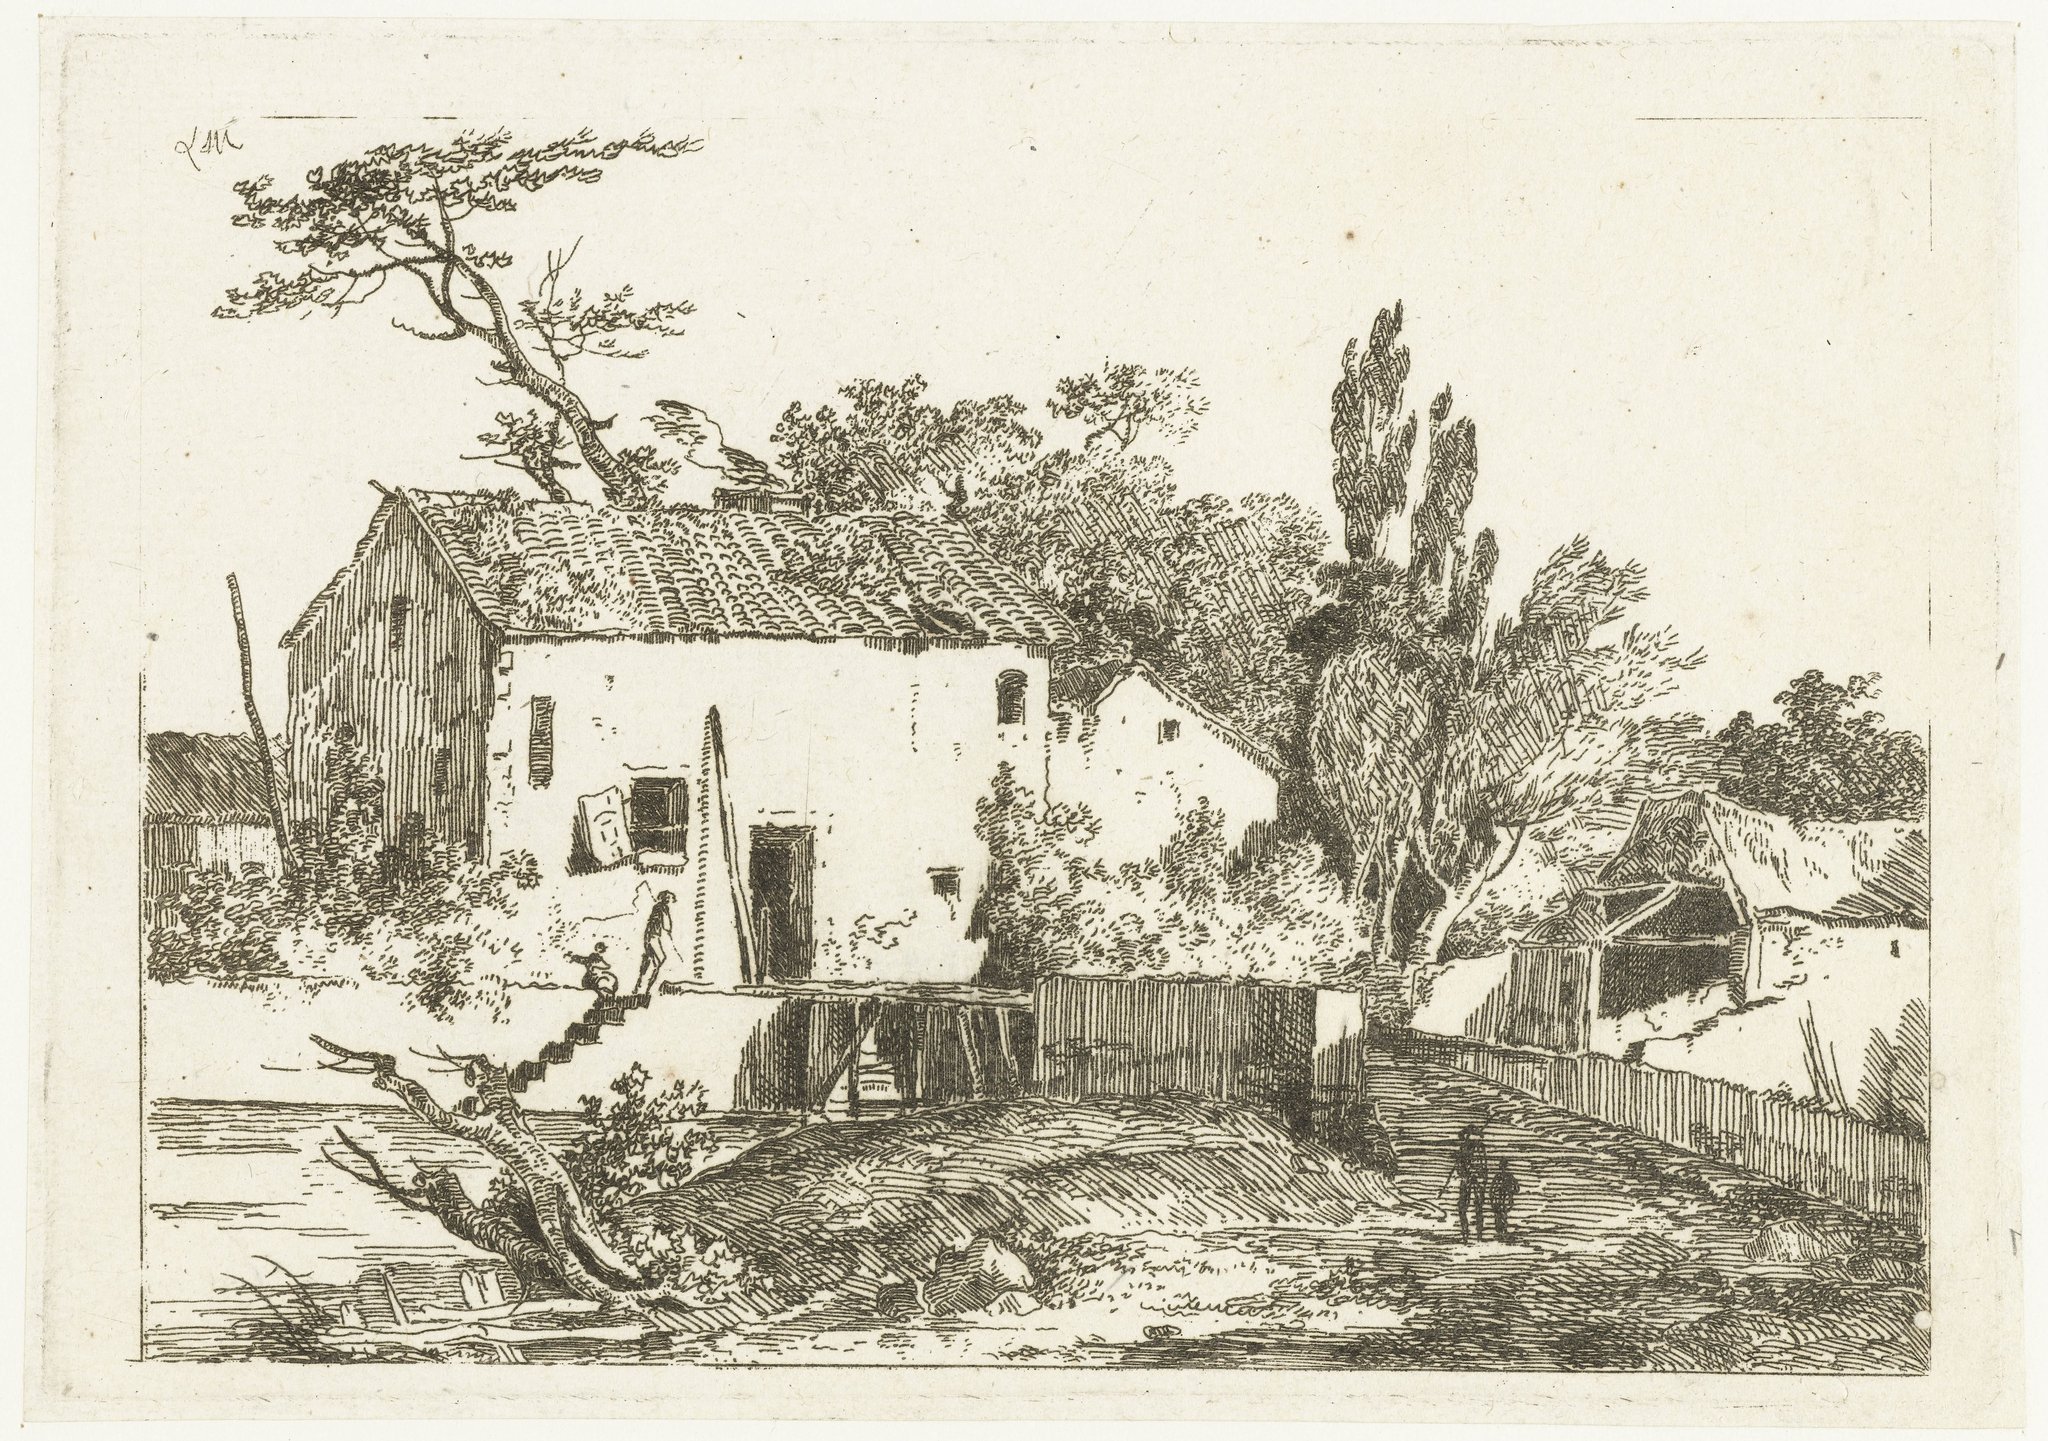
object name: print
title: Landweg naar een huis aan het water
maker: louis gabriel moreau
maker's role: draughtsman, print maker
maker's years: 1740-1806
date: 1770-1779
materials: paper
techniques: etching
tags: farm or solitary house in landscape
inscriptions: collector's mark: Lugt 2200, collector's mark: Lugt 2228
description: Een weg met een brug over het water, leidend naar een stenen huis met bijgebouwtjes.